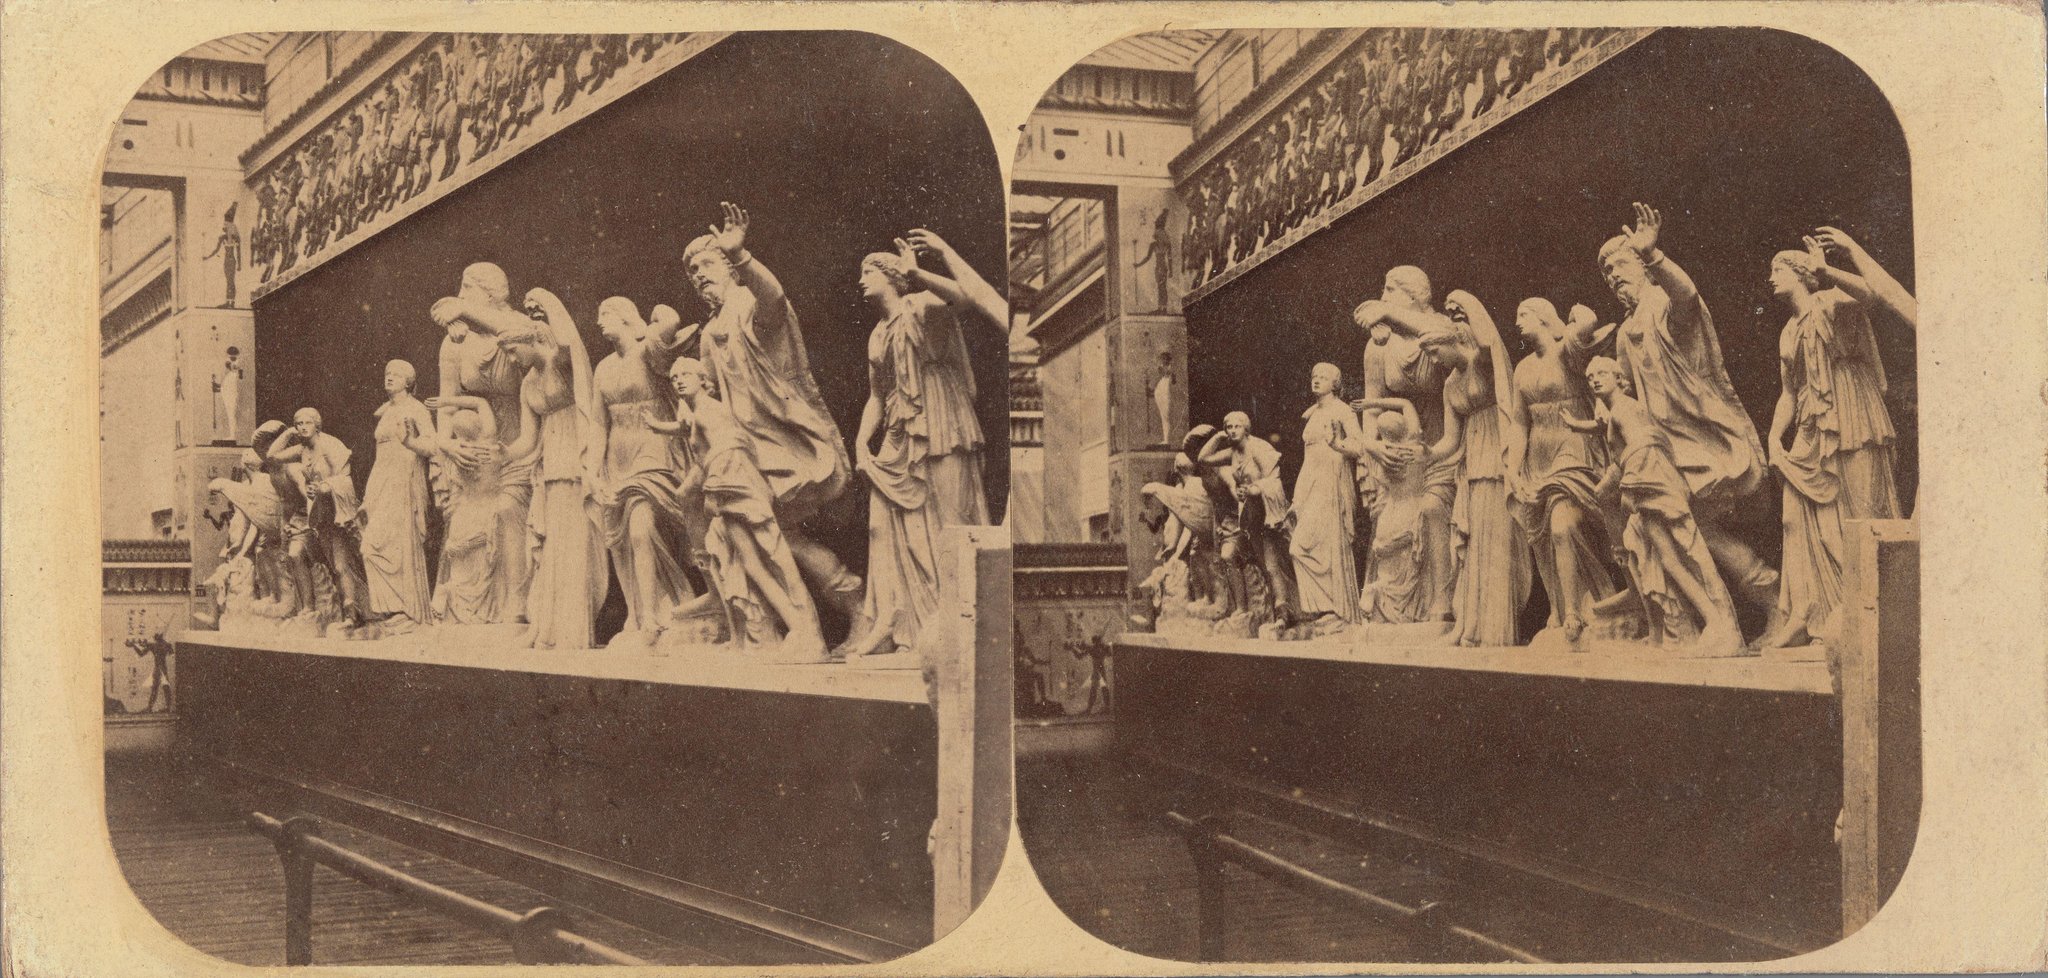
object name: stereograph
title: Interieur van de beeldengalerij in Crystal Palace in Sydenham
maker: Anonymous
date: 1870-1890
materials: cardboard, paper, photographic support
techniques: albumen print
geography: crystal palace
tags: gallery of sculptures